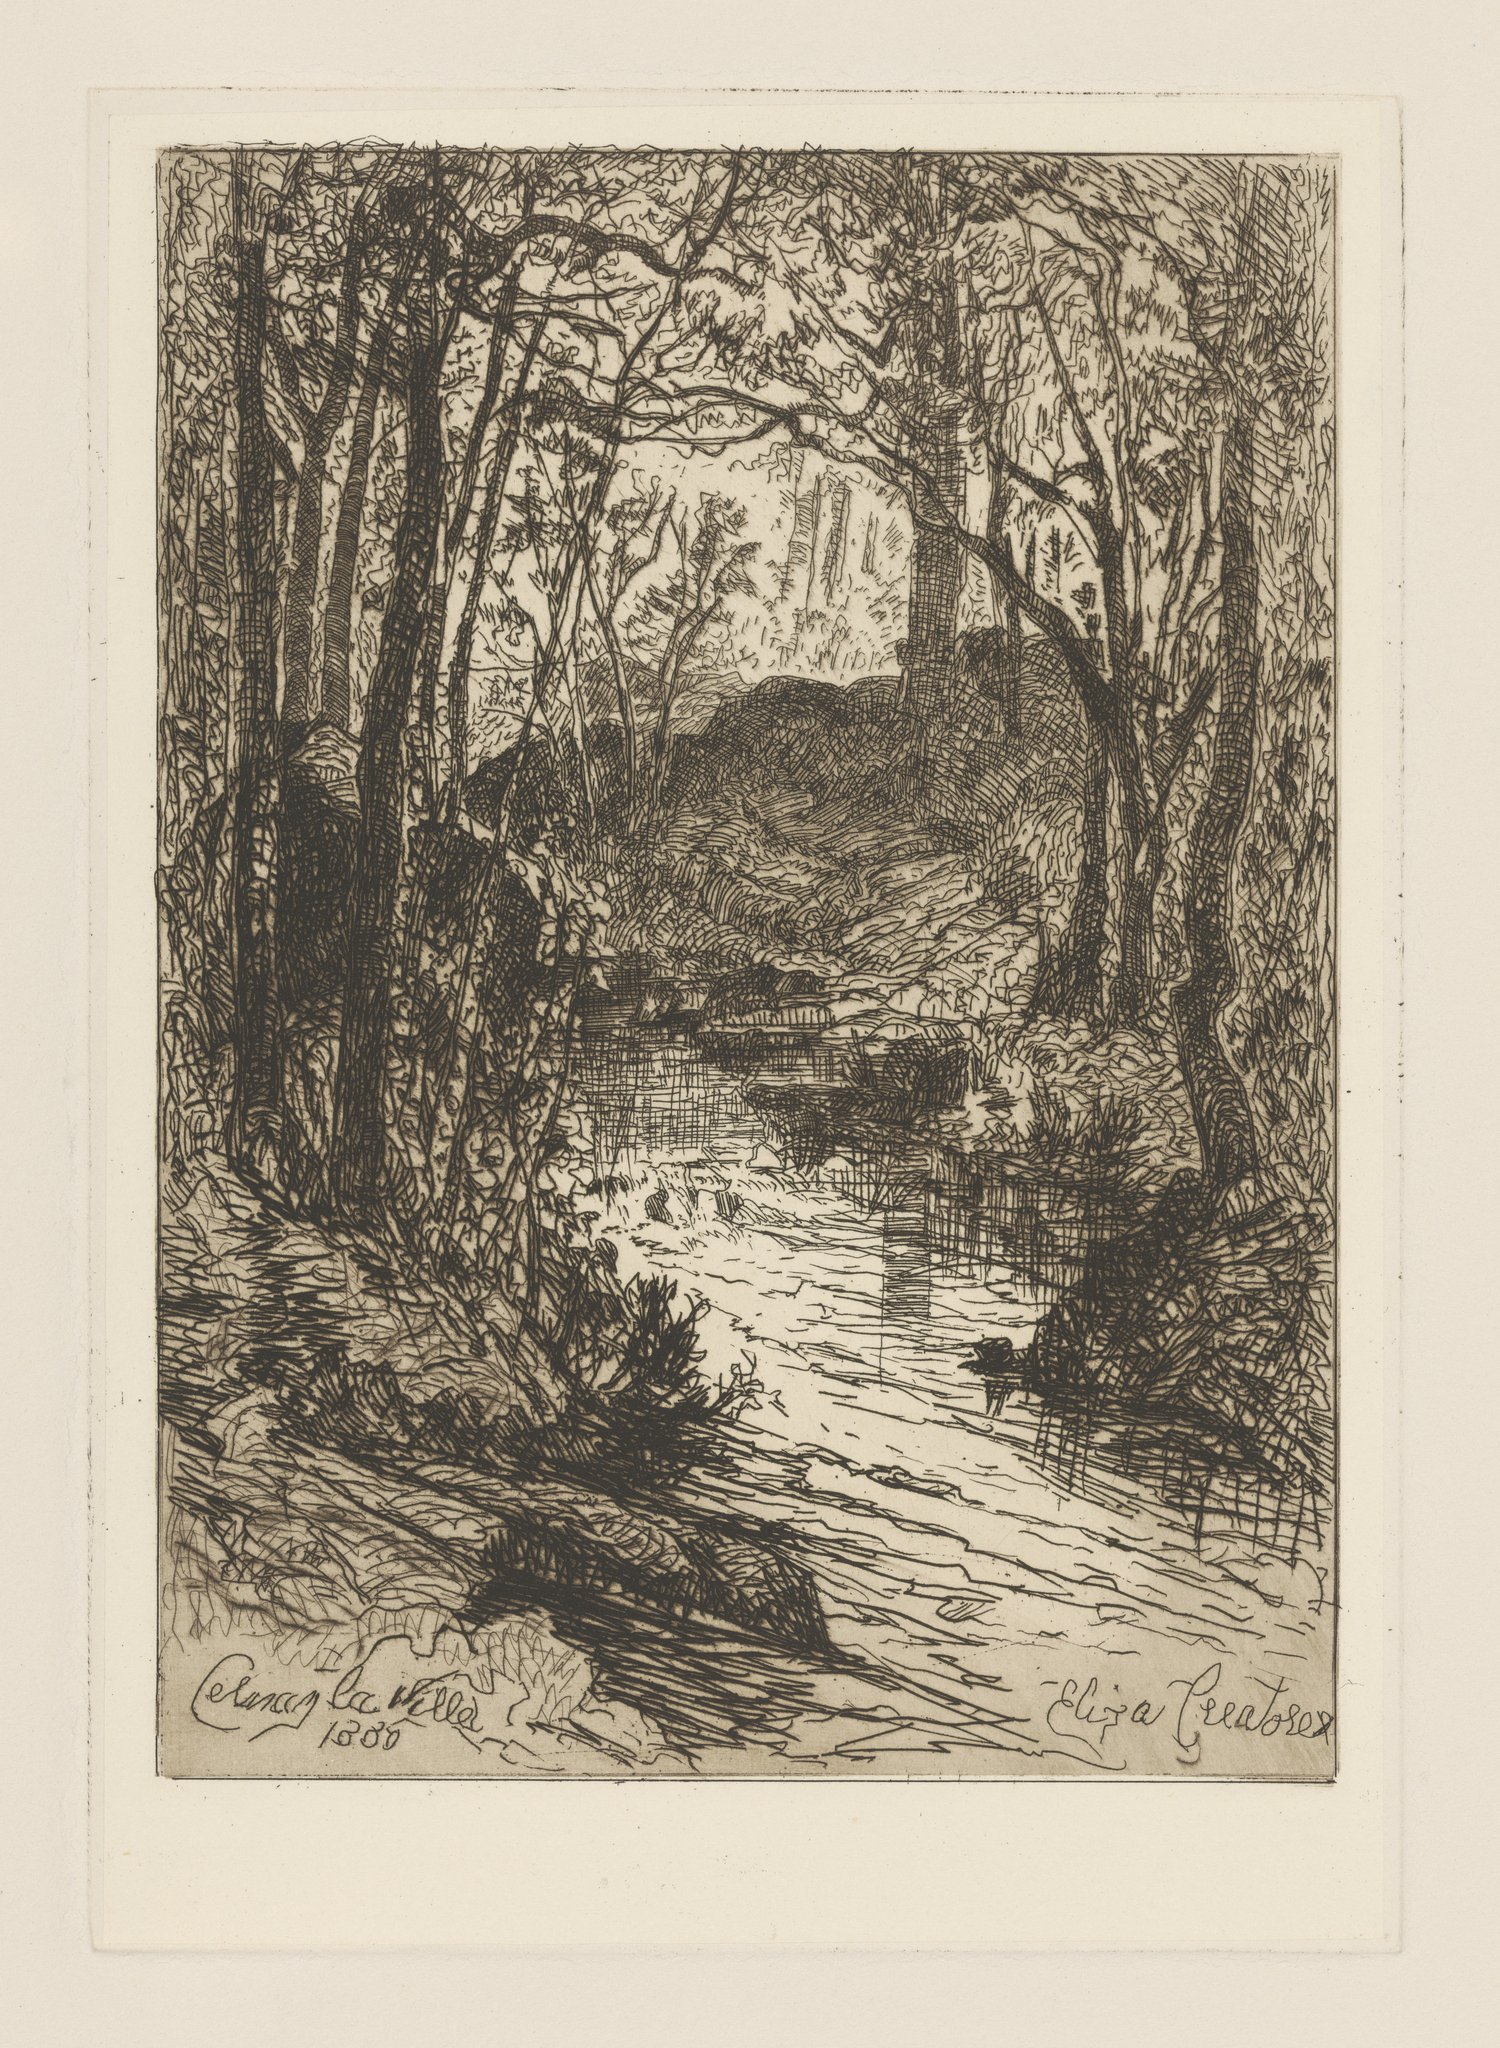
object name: print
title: Cerway La Ville, France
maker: eliza pratt greatorex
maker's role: artist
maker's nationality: american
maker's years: 1819-1897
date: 1880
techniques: printmaking, etching